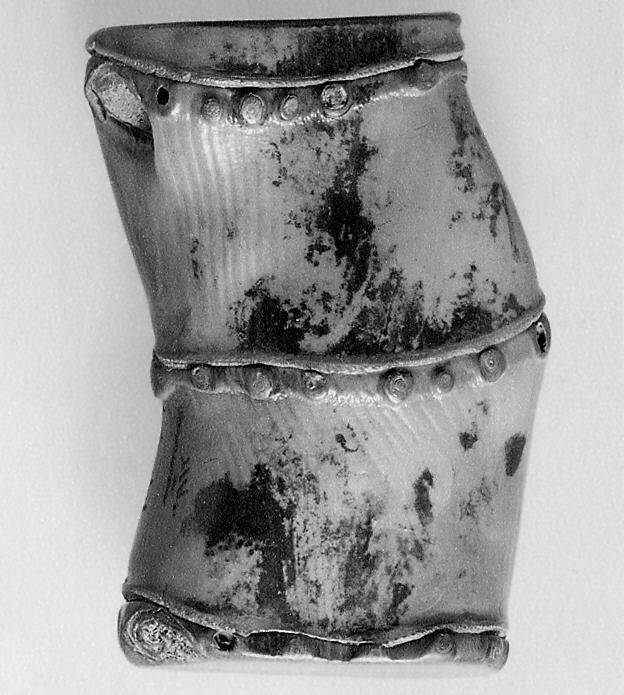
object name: seal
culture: chinese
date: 1736-1795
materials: bamboo